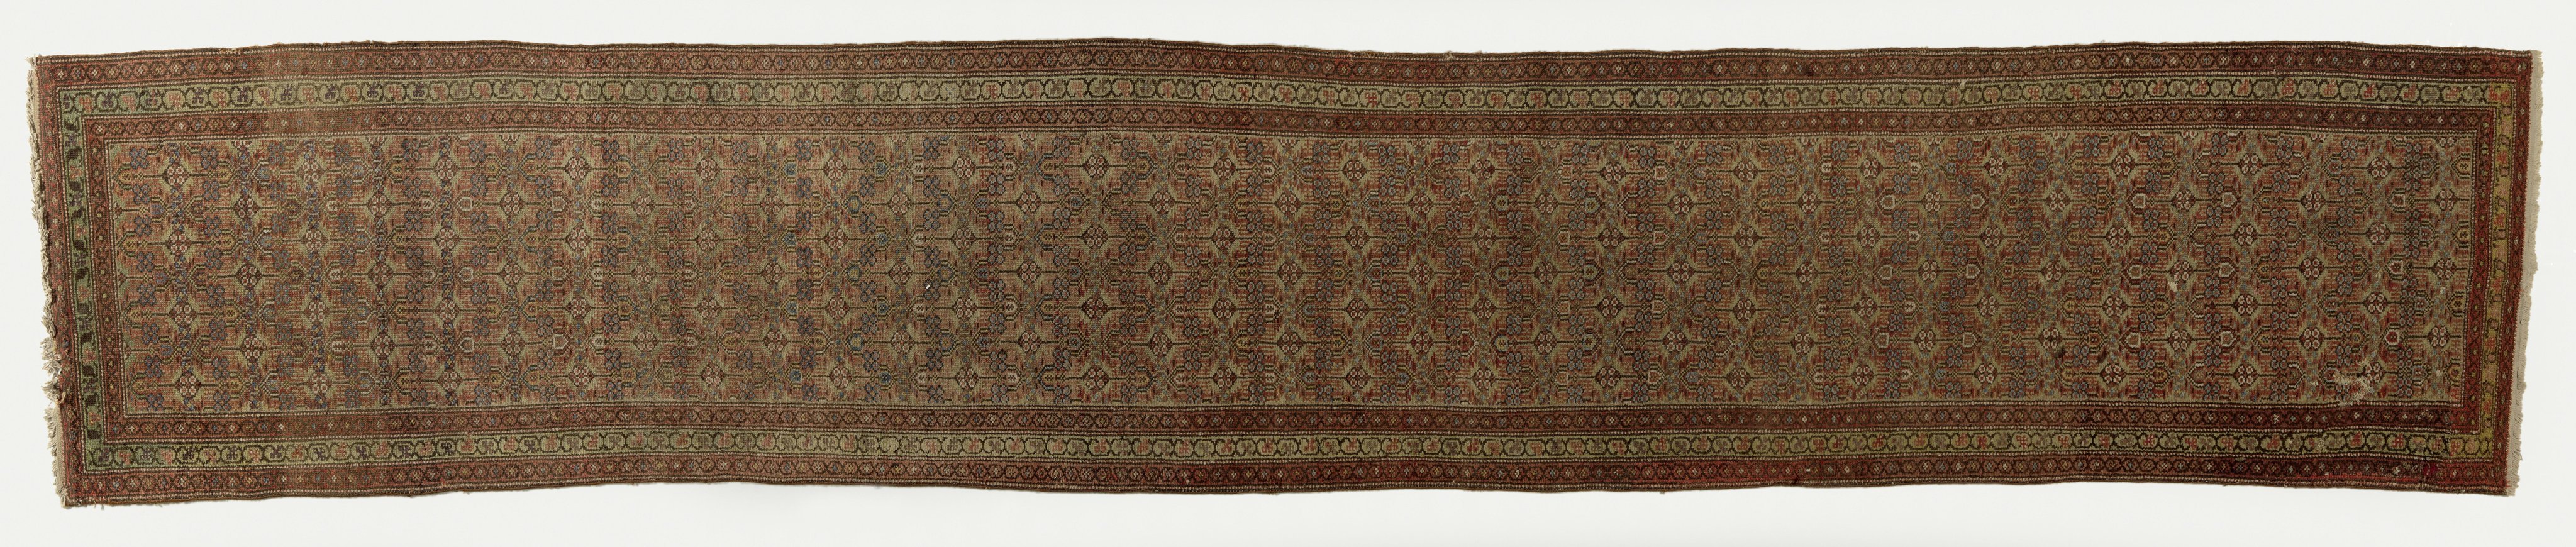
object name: oriental rug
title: Oosters tapijt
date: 1850-1900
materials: wool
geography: central persia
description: Oosters tapijt in loperformaat, waarvan het middenveld versierd is met een rasterpatroon. In het haart van de ruiten staan rozetten. De rand is versierd met stijve florale ornamenten.